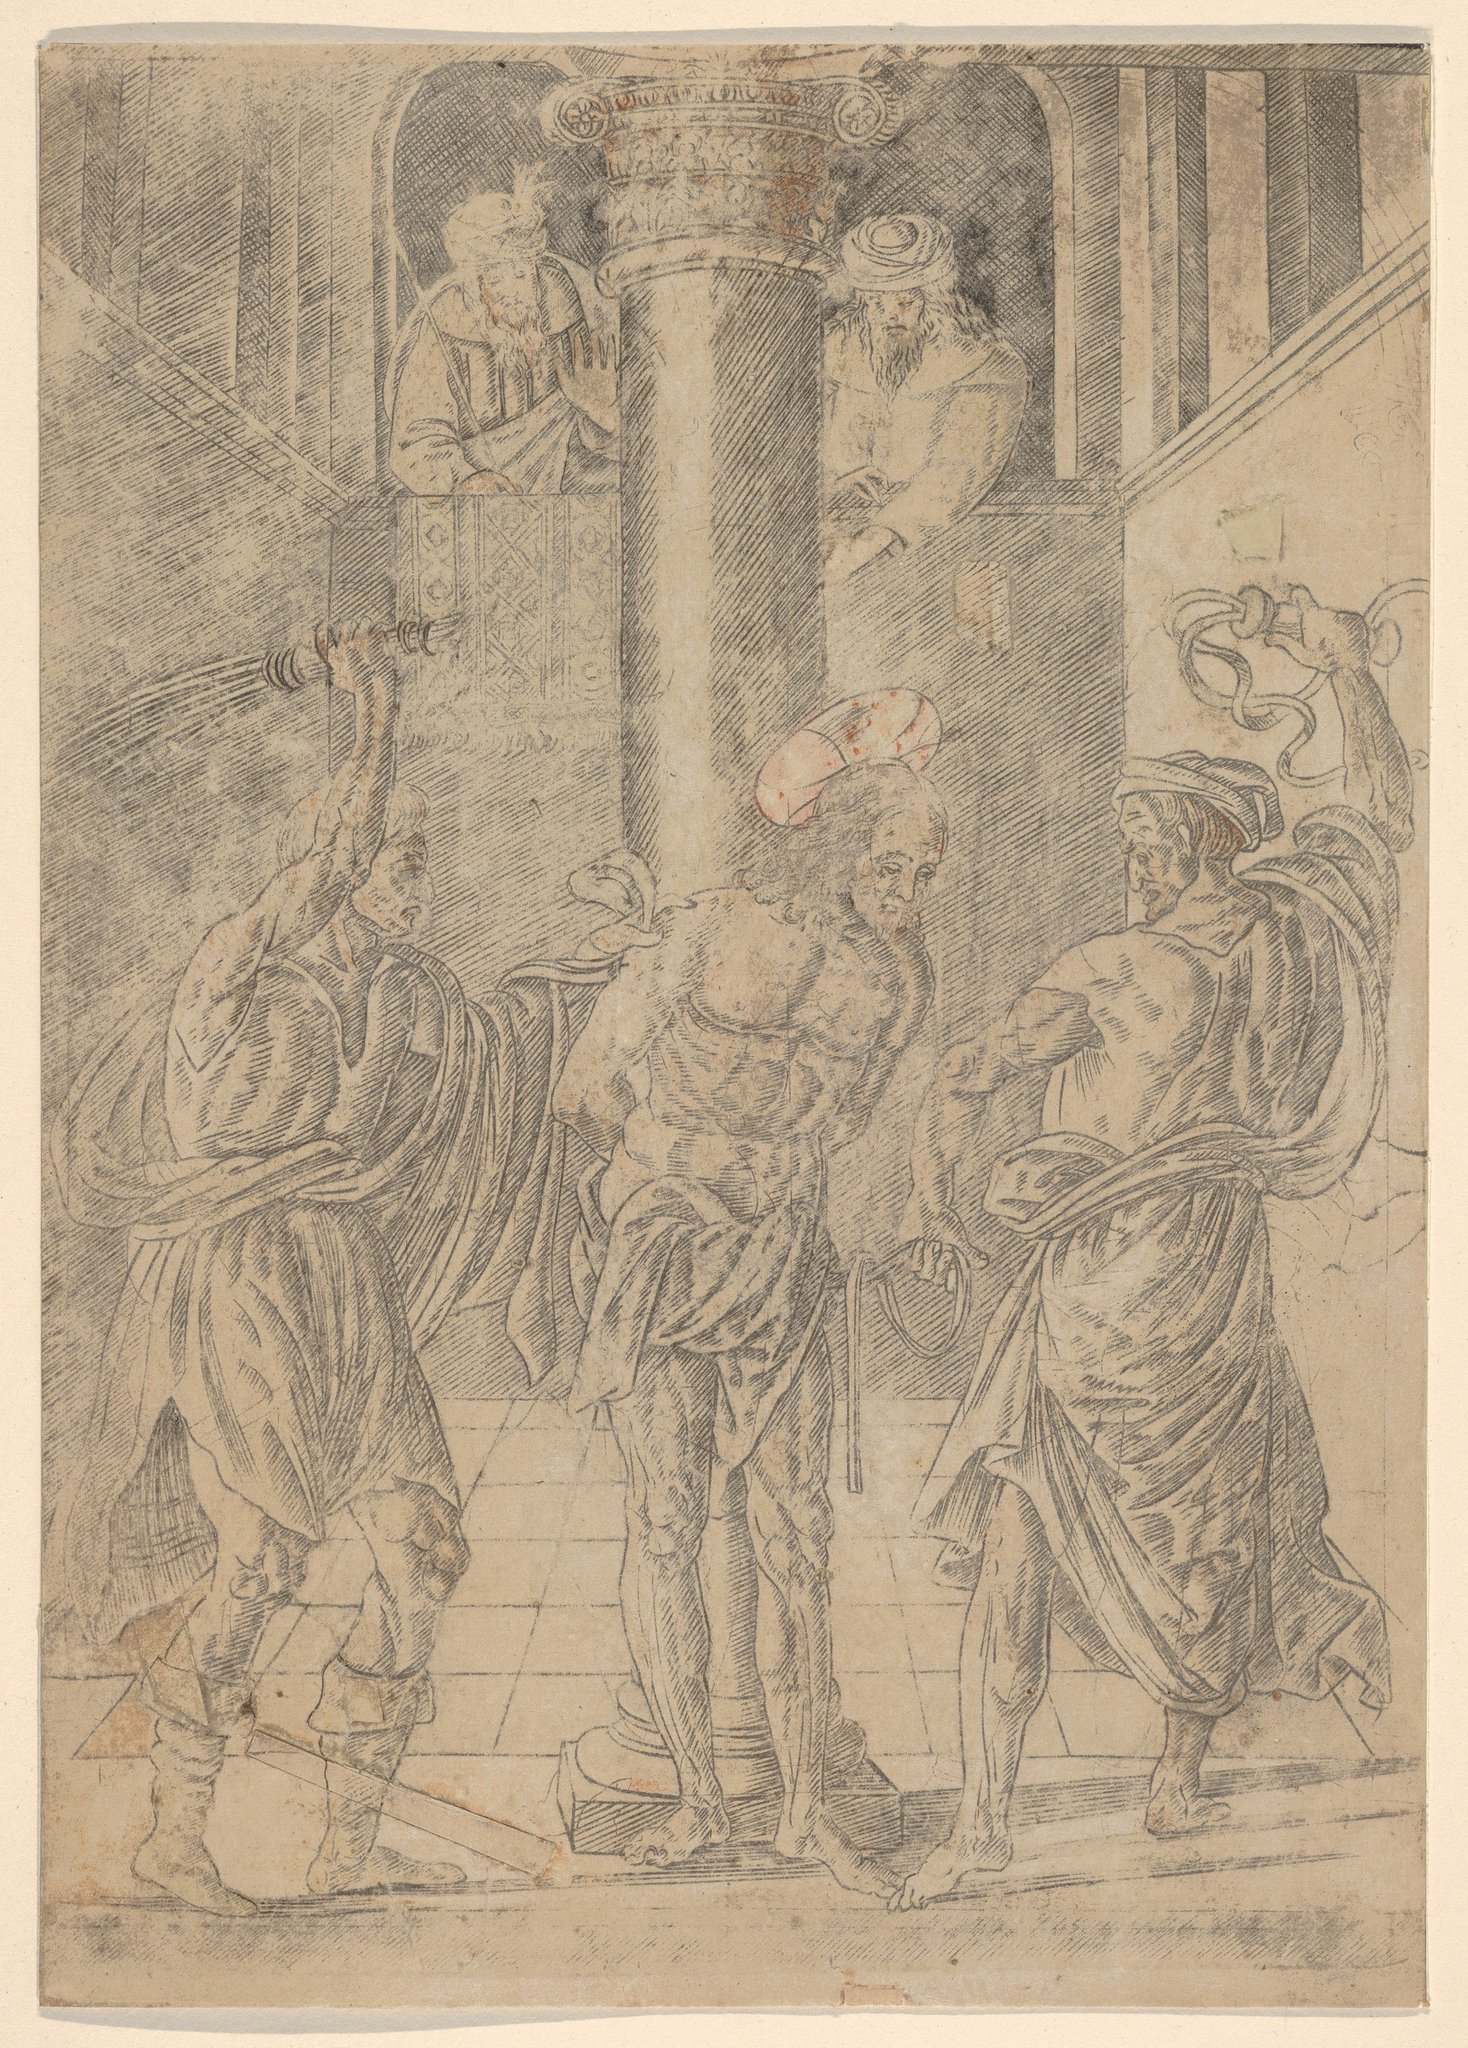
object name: print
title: The Scourging of Christ, from Life of the Virgin and Christ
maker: francesco rosselli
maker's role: artist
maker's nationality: italian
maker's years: 1448-1527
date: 1480-1500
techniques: engraving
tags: suffering,men,jesus,punishment